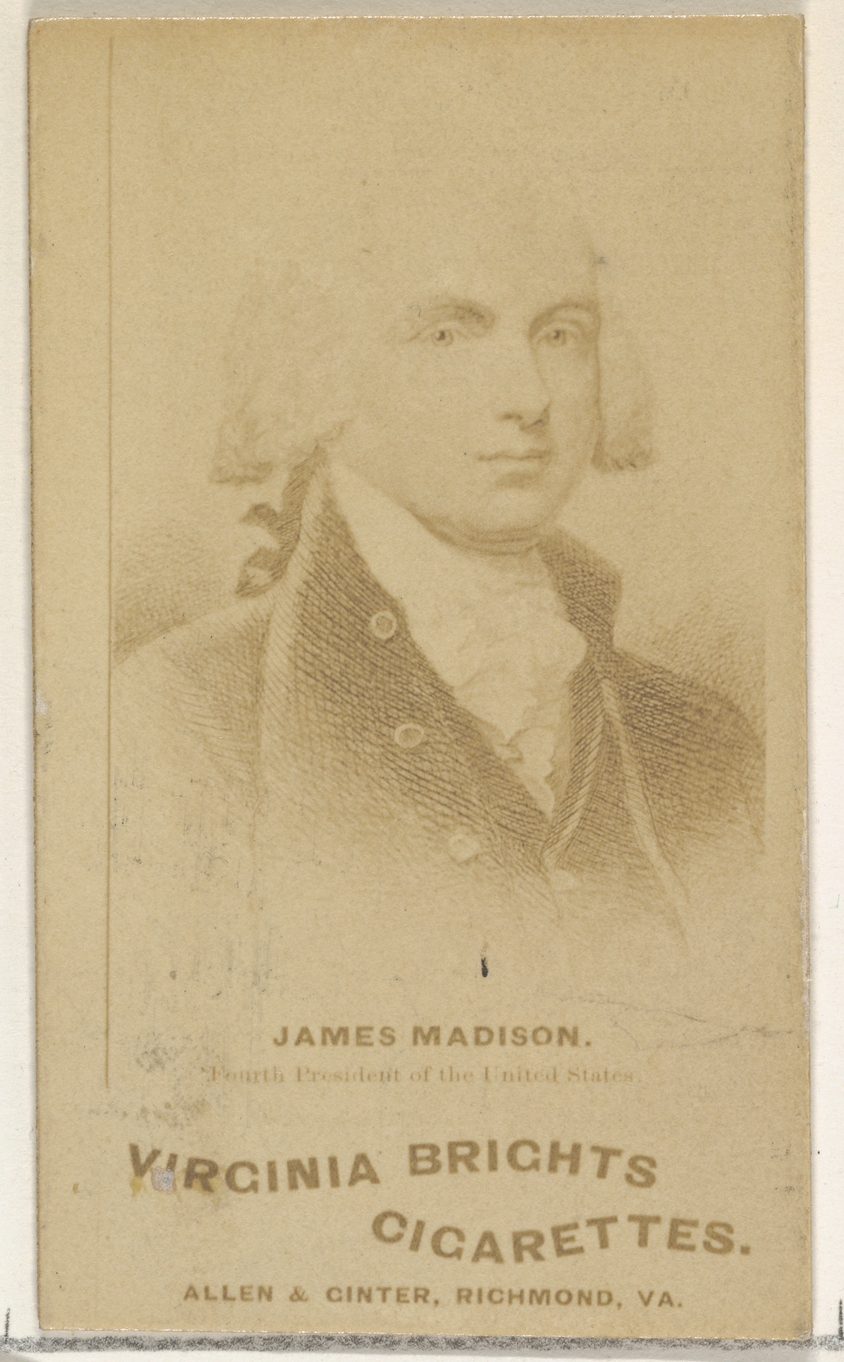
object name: photograph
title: James Madison, from the Presidents of the United States series (N51) for Virginia Brights Cigarettes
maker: allen & ginter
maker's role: publisher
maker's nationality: american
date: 1885-1889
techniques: albumen silver print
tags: men,presidents